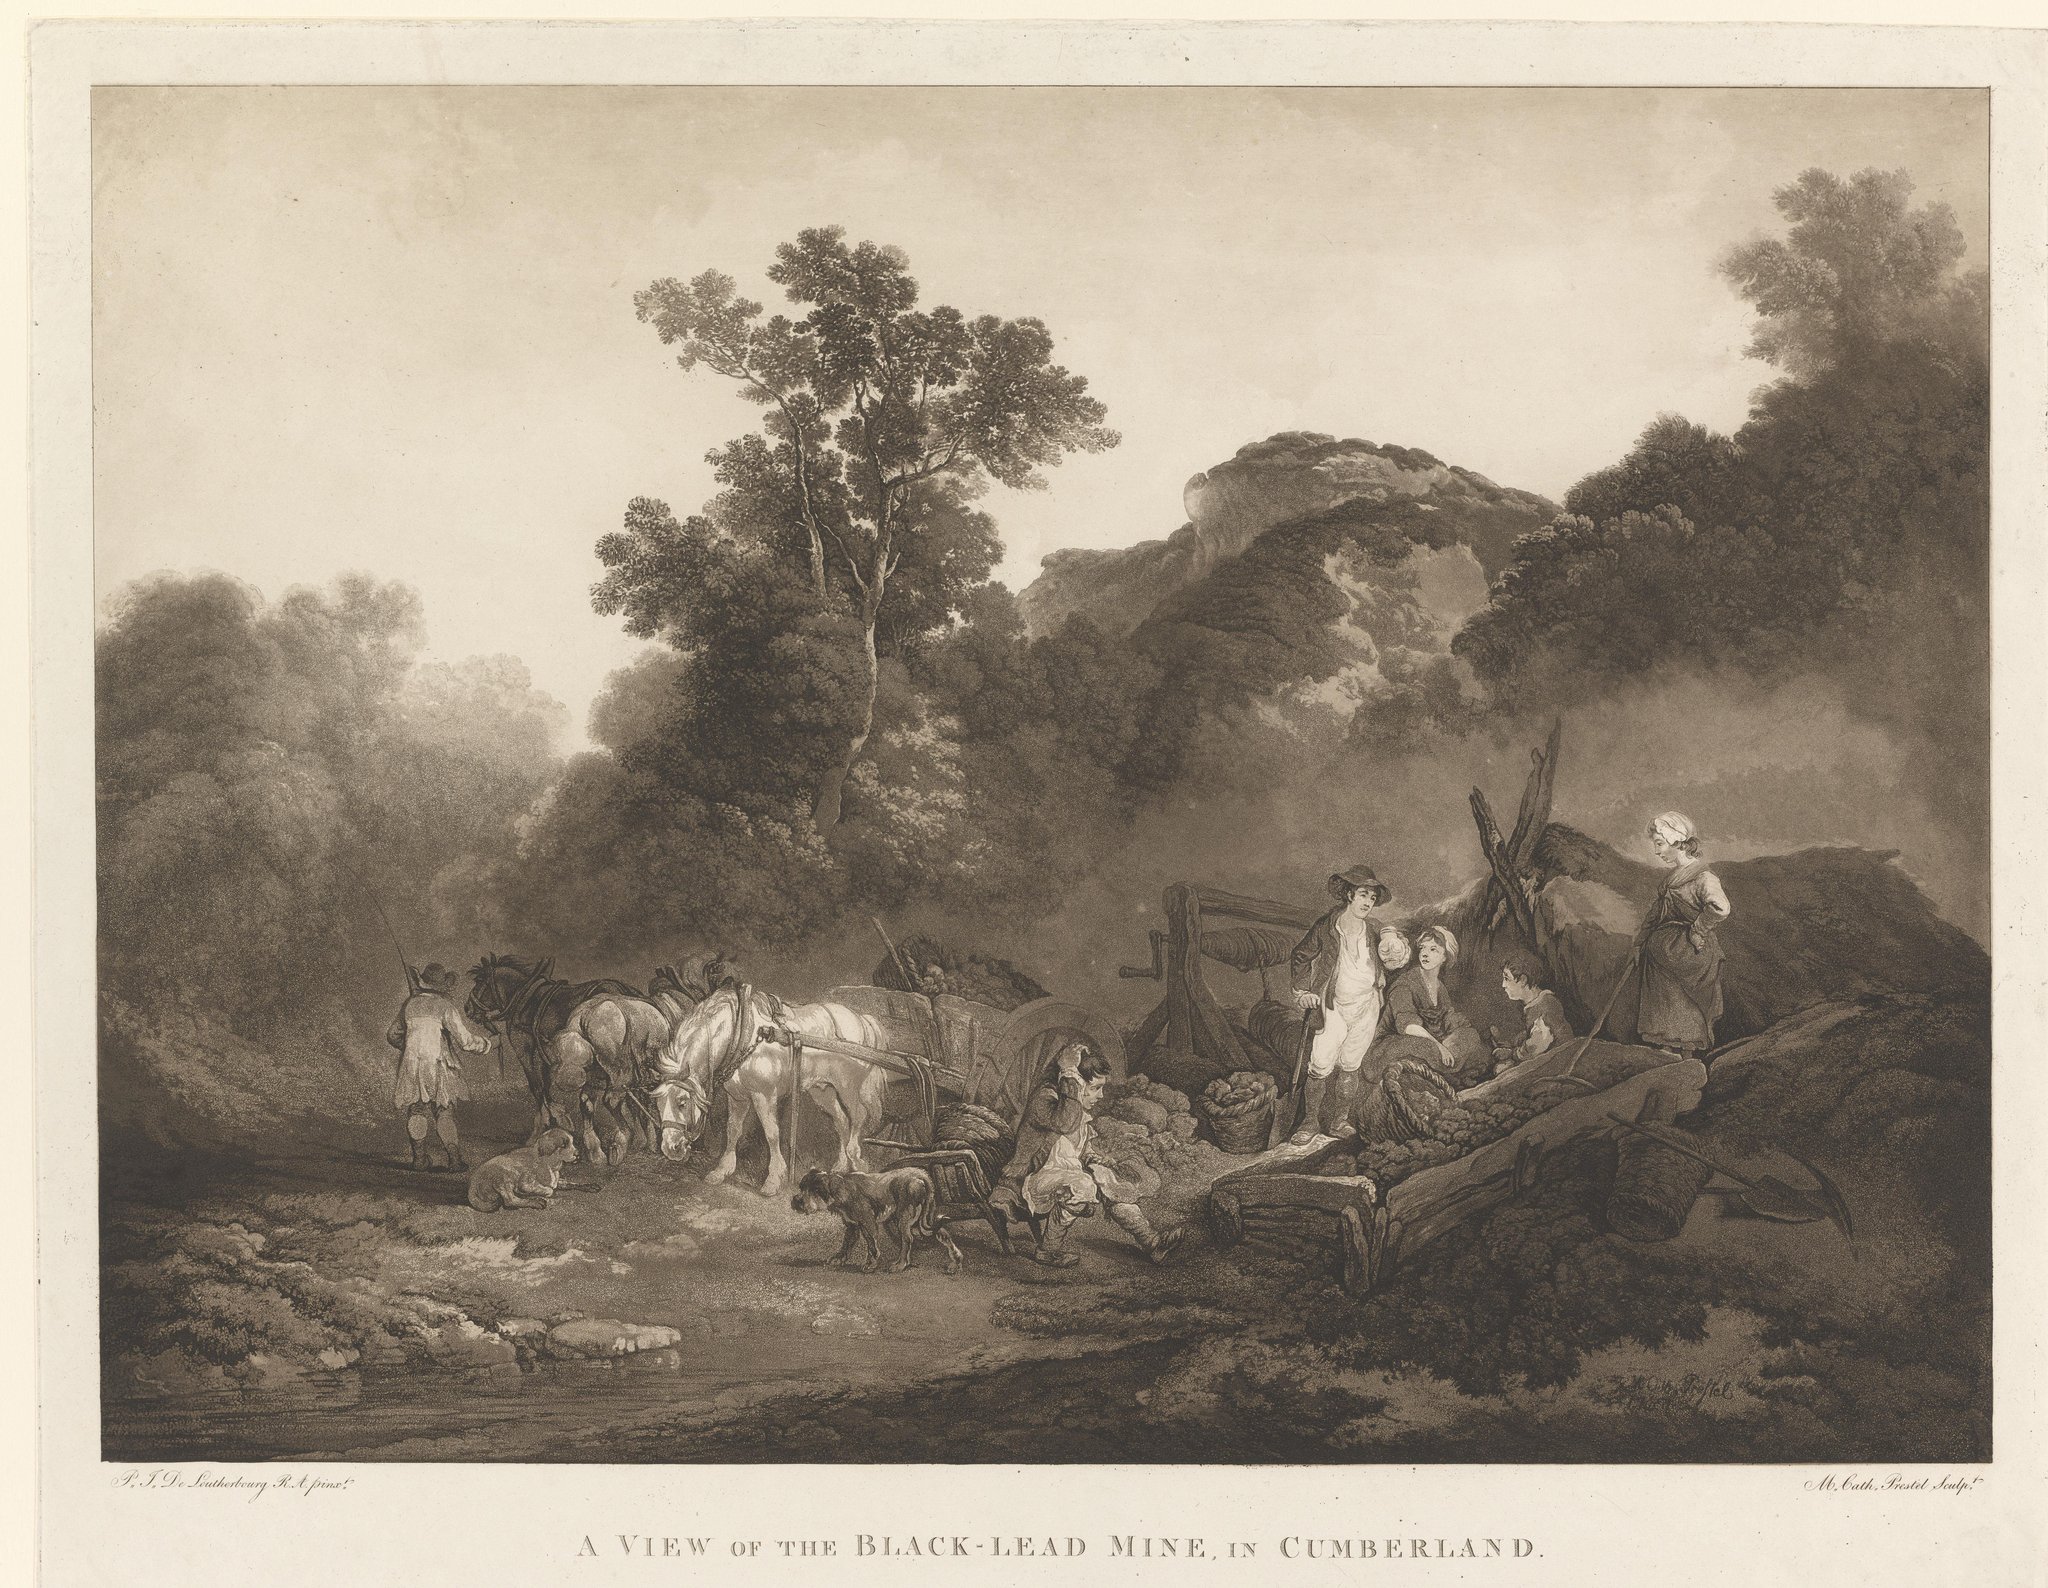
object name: print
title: A View of the Black-Lead Mine, in Cumberland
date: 1788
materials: paper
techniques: aquatint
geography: vienna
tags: miner, (high) hill (+ landscape with figures, staffage)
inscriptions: collector's mark: Lugt 2228, number: ‘No. 1896.’